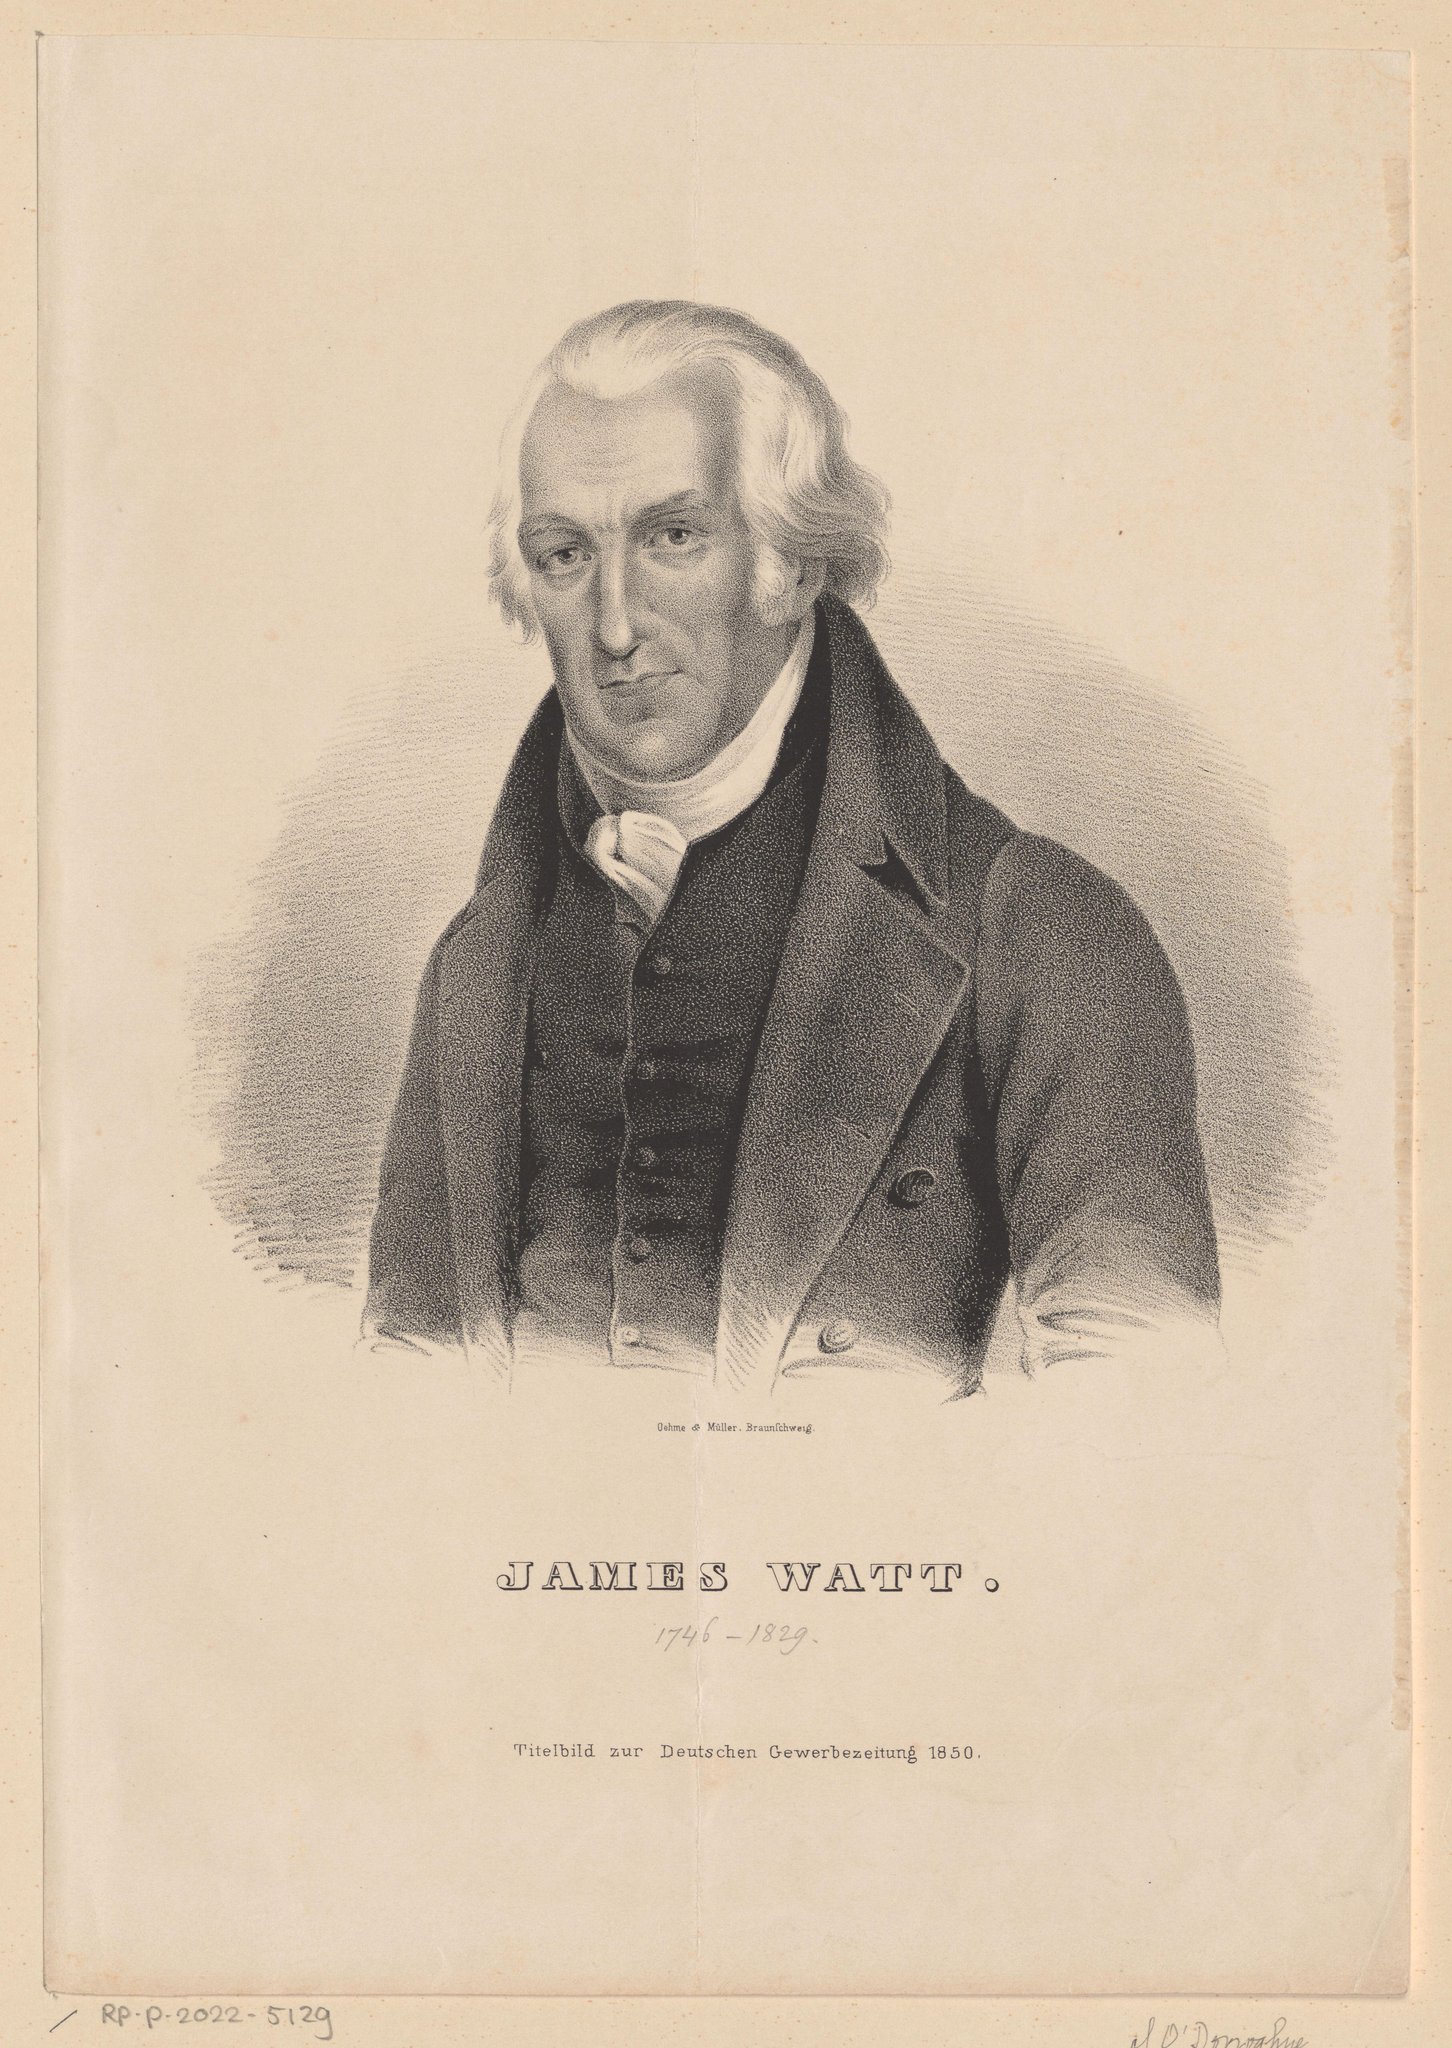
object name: print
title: Portret van James Watt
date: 1850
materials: paper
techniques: lithograph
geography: leipzig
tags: historical persons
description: Prent uit: Deutsche Gewerbezeitung, 1850.